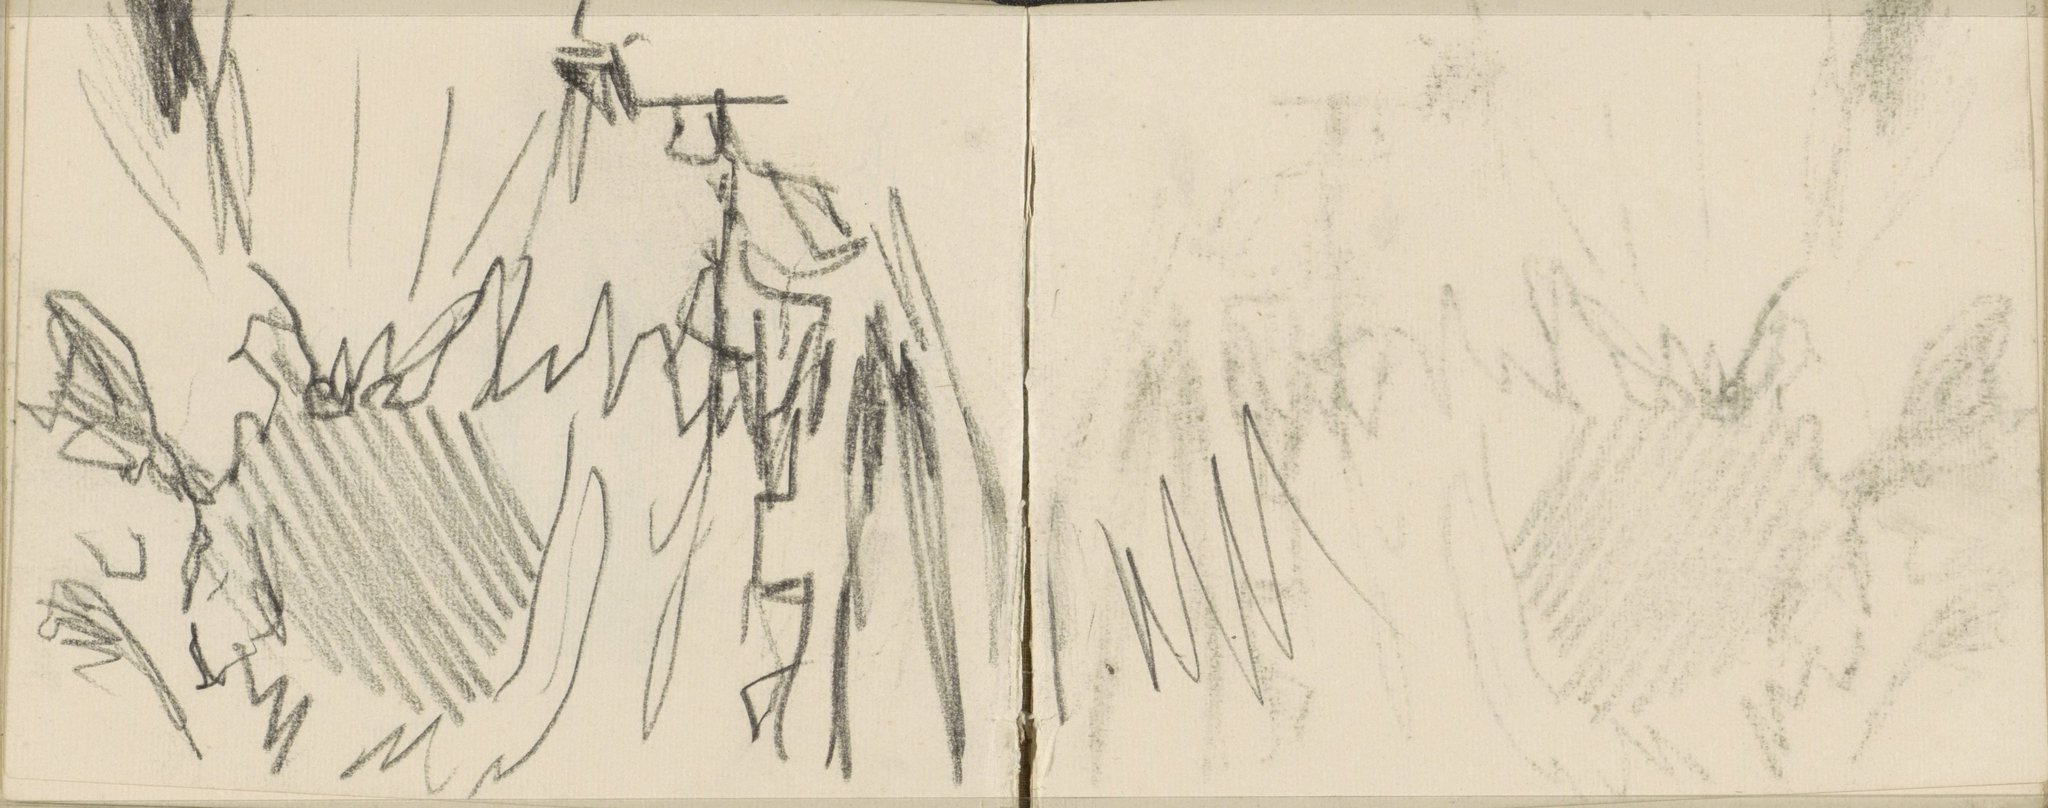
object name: sketchbook leaf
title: Gezicht in Amsterdam met wolkenlucht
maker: george hendrik breitner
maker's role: draughtsman, painter, print maker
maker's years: 1857-1923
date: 1885-1898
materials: chalk, paper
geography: amsterdam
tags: city-view, and landscape with man-made constructions, clouds, civic architecture; edifices; dwellings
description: Pagina 39 en pagina 40 uit een schetsboek met 32 bladen.